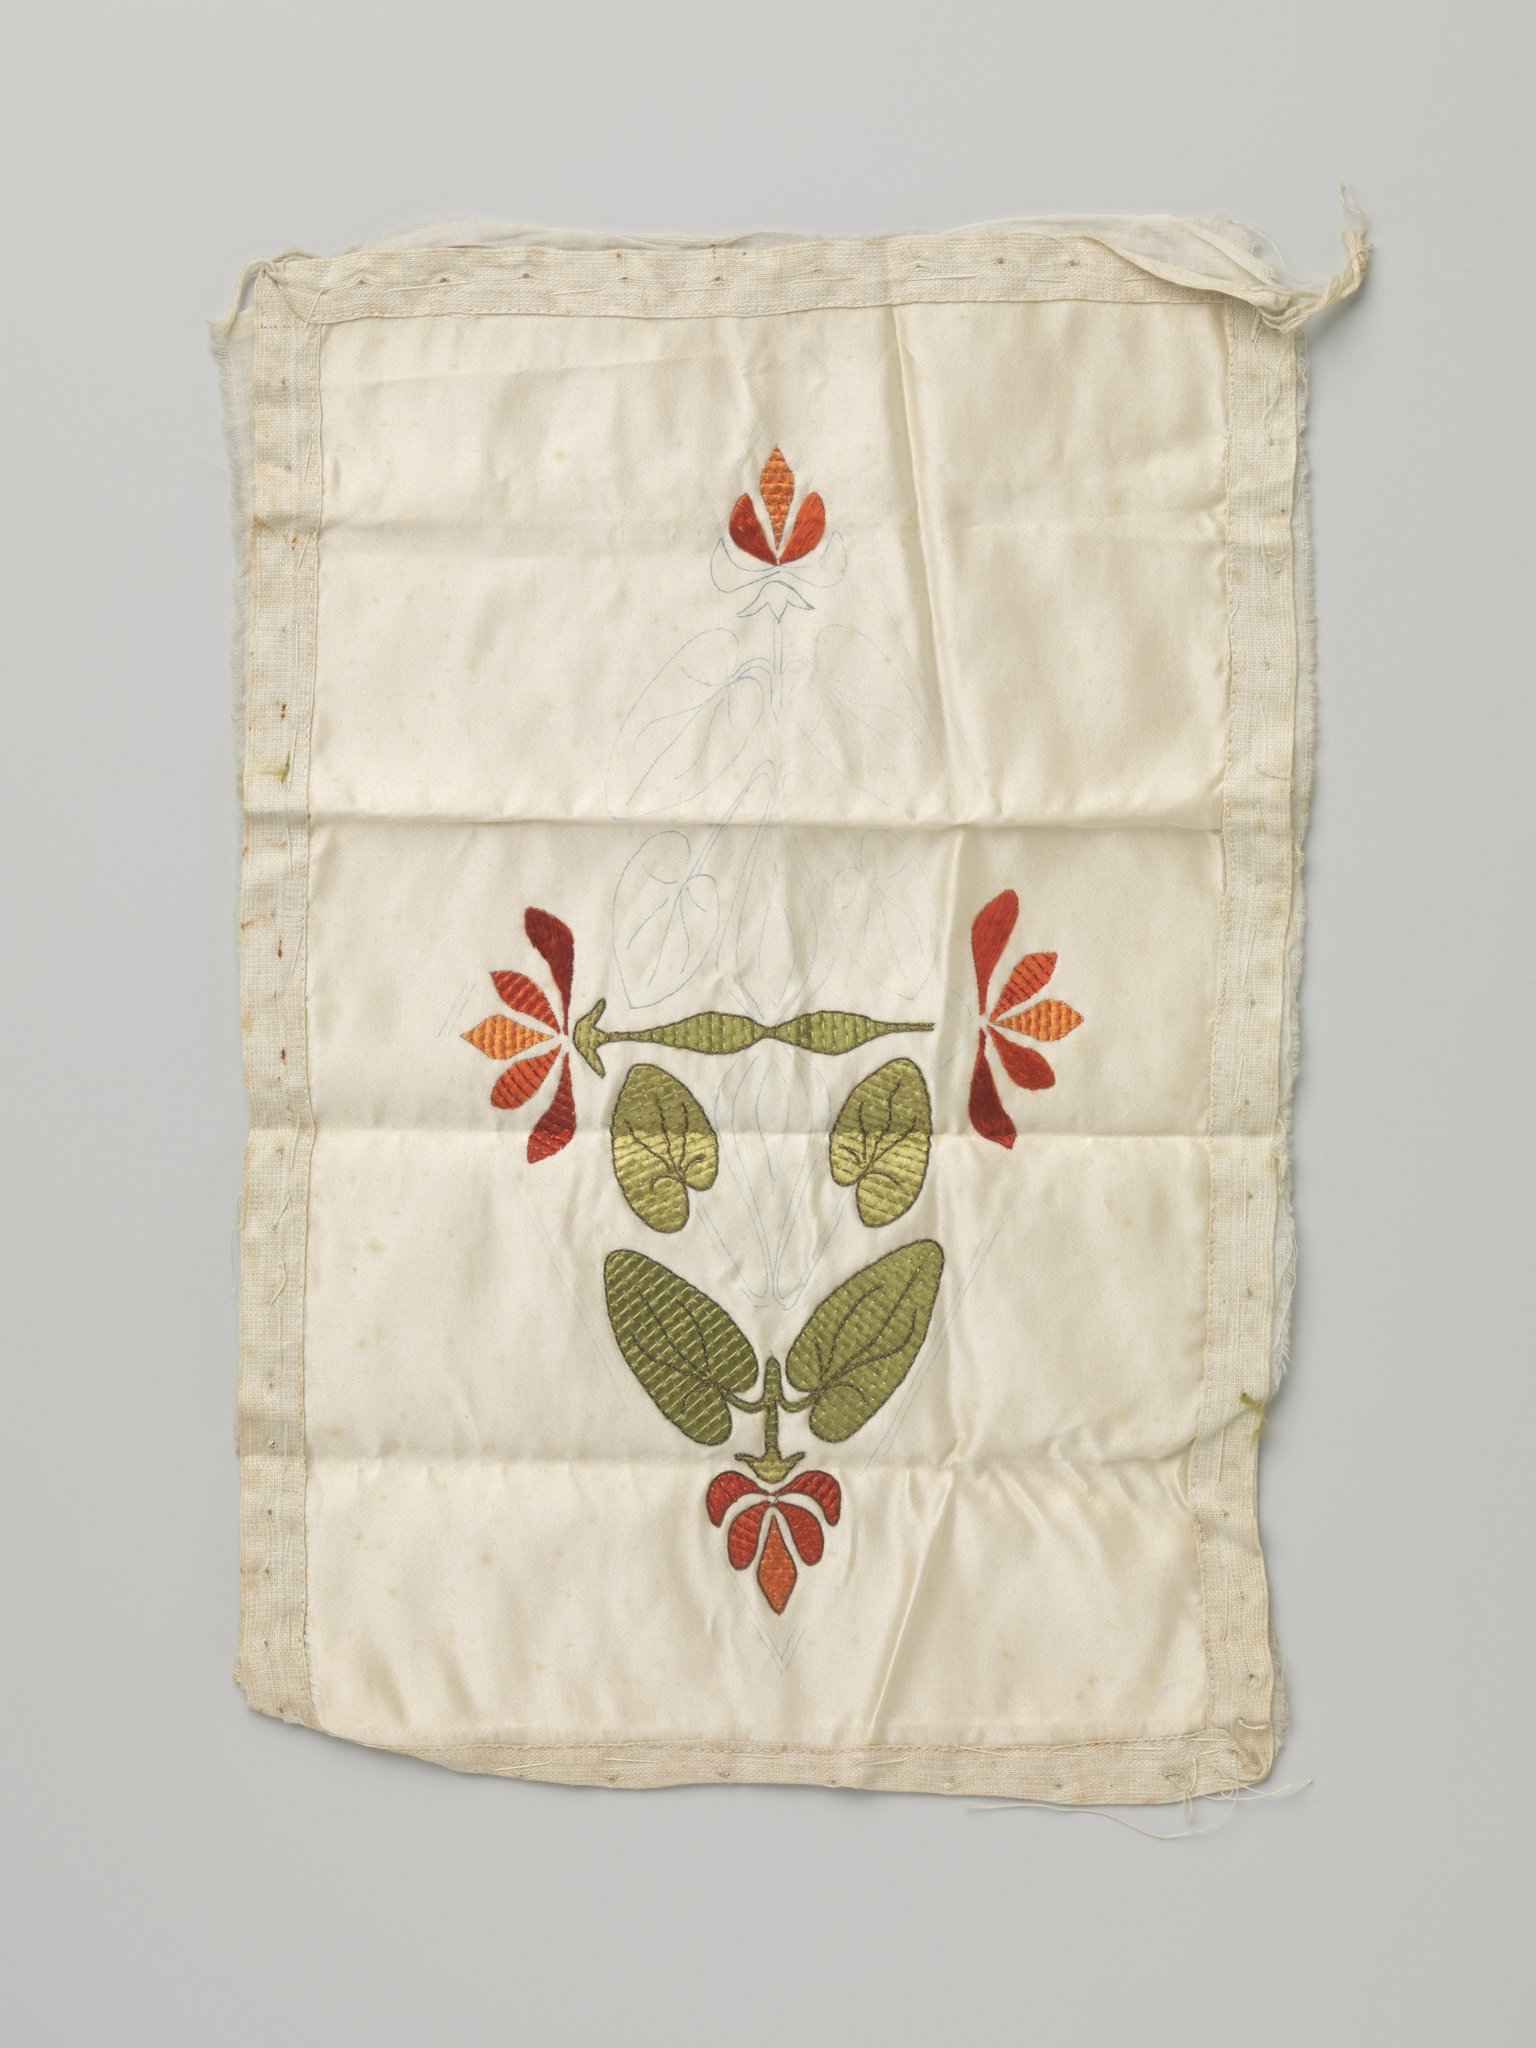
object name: handwerk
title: Handwerk met geborduurde waterlelies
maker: aagje tiket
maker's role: artisan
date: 1900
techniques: embroidered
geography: amsterdam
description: Handwerk met in ruitvorm rode waterlelies en gouddraadranken in Jugendstil op een wit satijnen rechthoek in gelegde spandraad (onvoltooid). Behorend tot serie van acht witte en tien gekleurde handwerken, vervaardigd door Aagje Tiket voor het behalen van de akte Fraaie en/of Nuttige handwerken aan de Industrieschool, BK-1974-105-A t/m R.